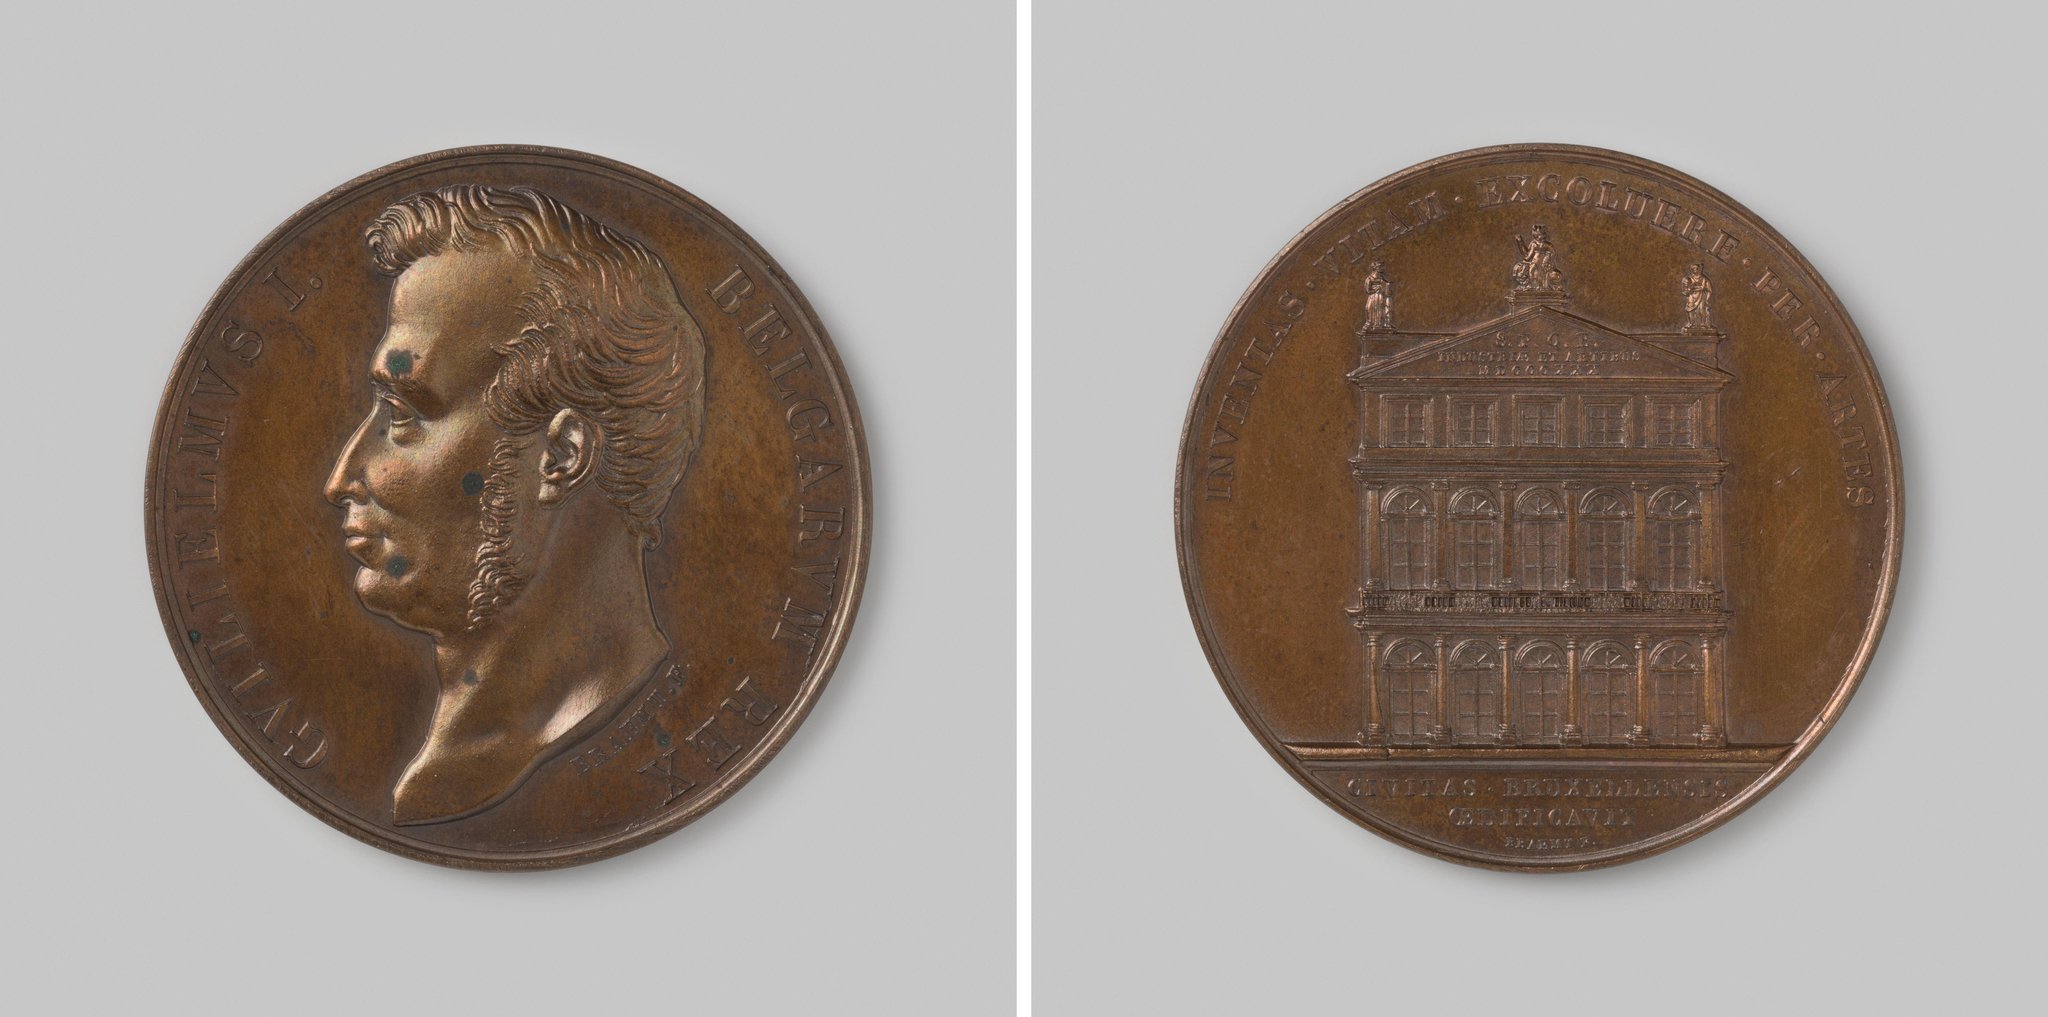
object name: history medal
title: Tentoonstelling van voortbrengselen van nijverheid te Brussel 1830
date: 1830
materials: bronze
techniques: striking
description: Bronzen penning, op de voorzijde het portret van Koning Willem I naar links met omschrift, op de keerzijde de gevel van het Paleis van Nijverheid te Brussel, met omschrift en afsnedetekst.